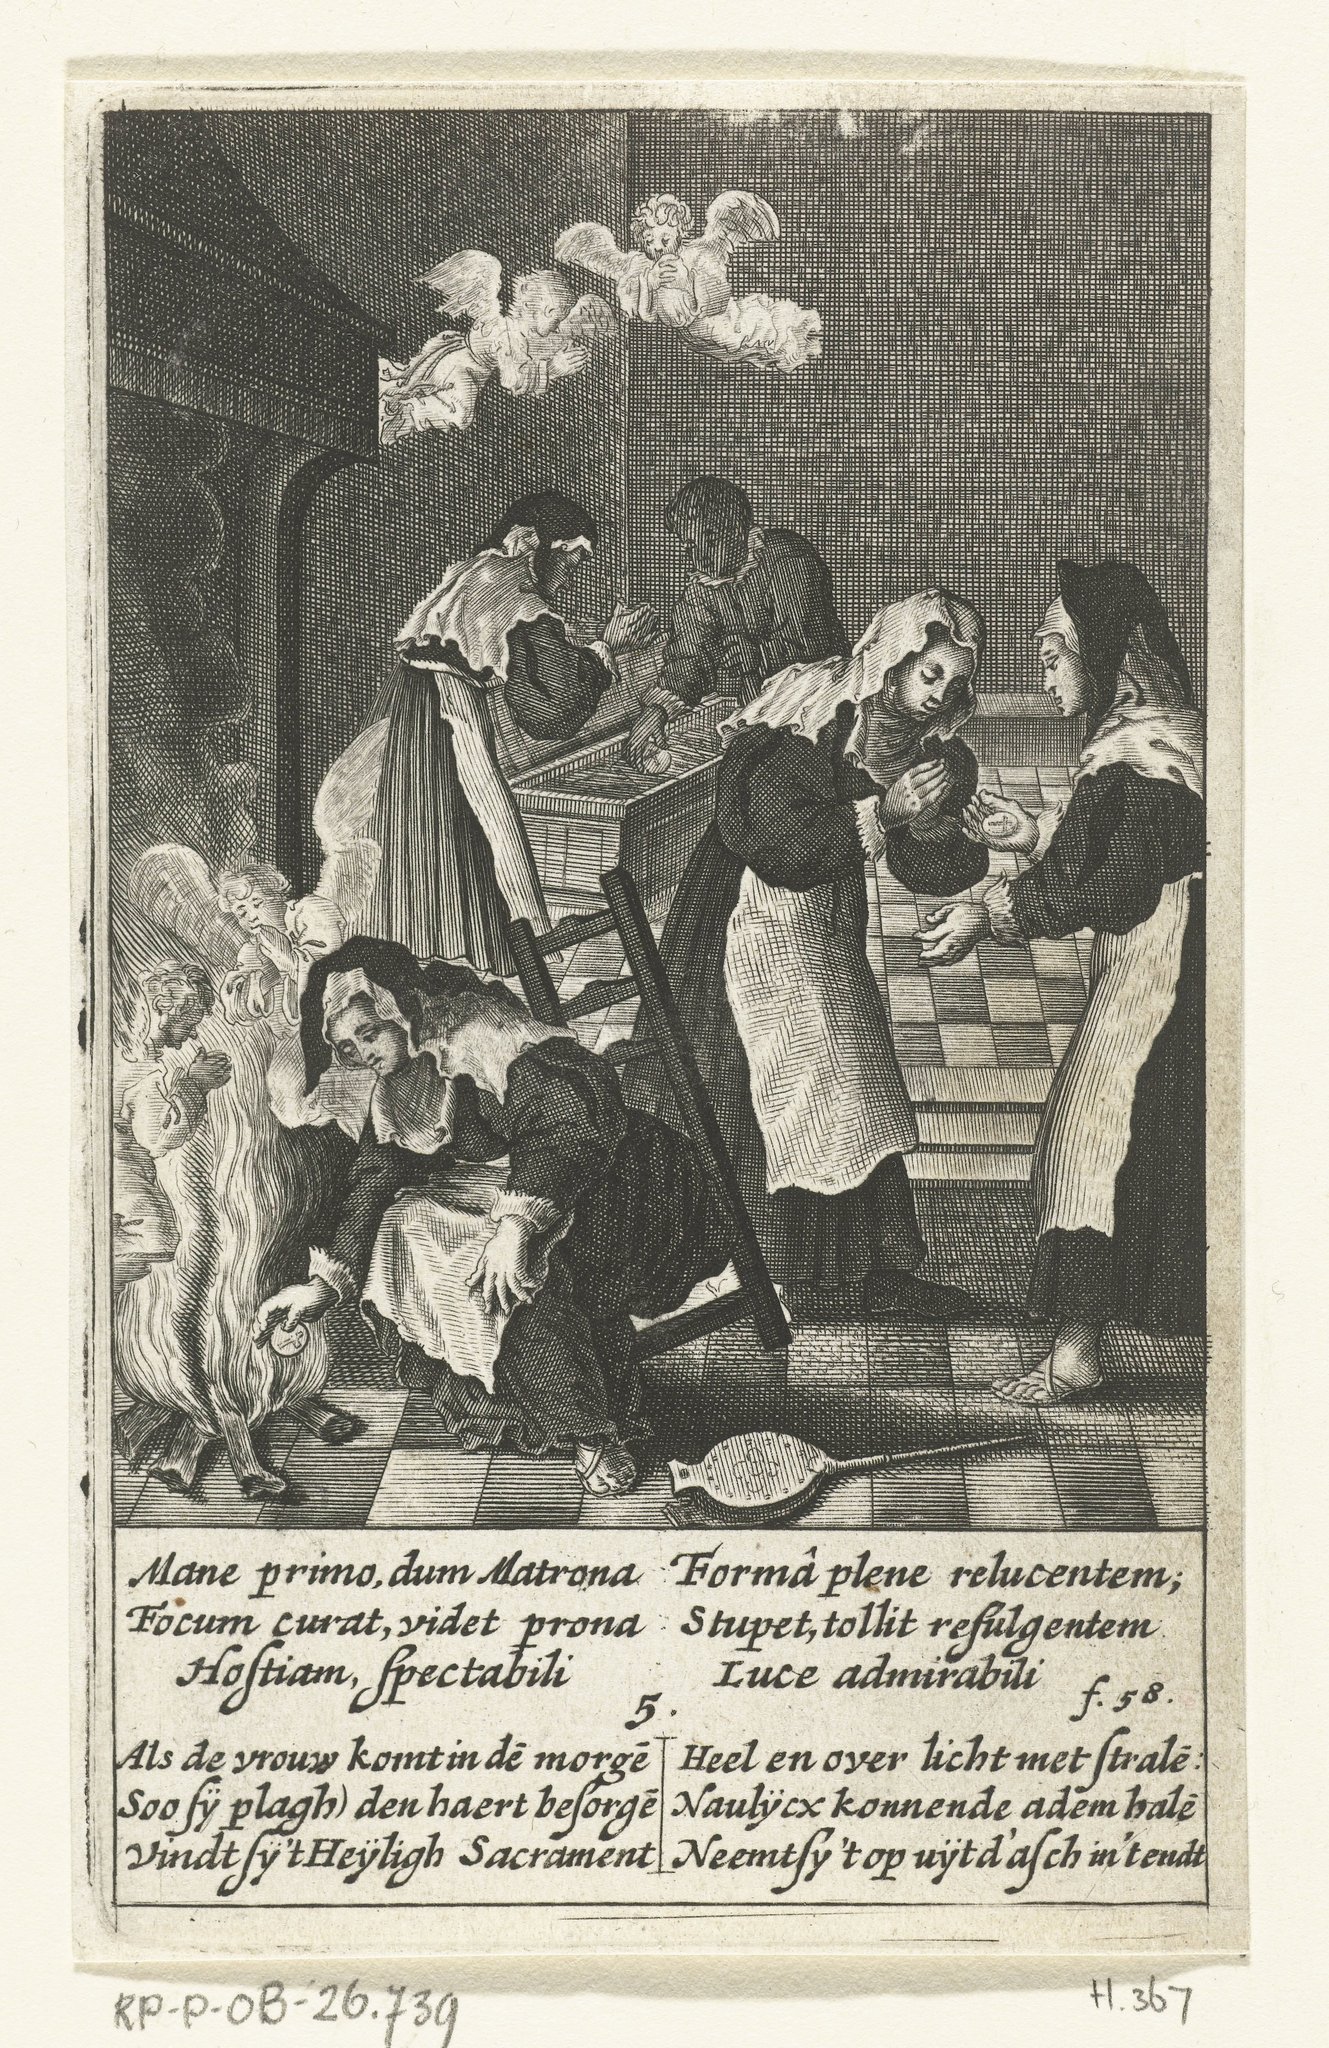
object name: book illustration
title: Mirakel van Amsterdam 1345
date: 1590-1633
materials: paper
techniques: engraving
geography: antwerp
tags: legends and miracles associated with the eucharist (or the host), patient, sick person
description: Prent uit: Leonardus Marius, Amstelredams eer ende opcomen, door de denckwaerdighe miraklen aldaer geschied aen ende door het H. Sacrament des Altaers Anno 1345, Antwerpen, Hendrick Aertssens, 1639, afb. 5